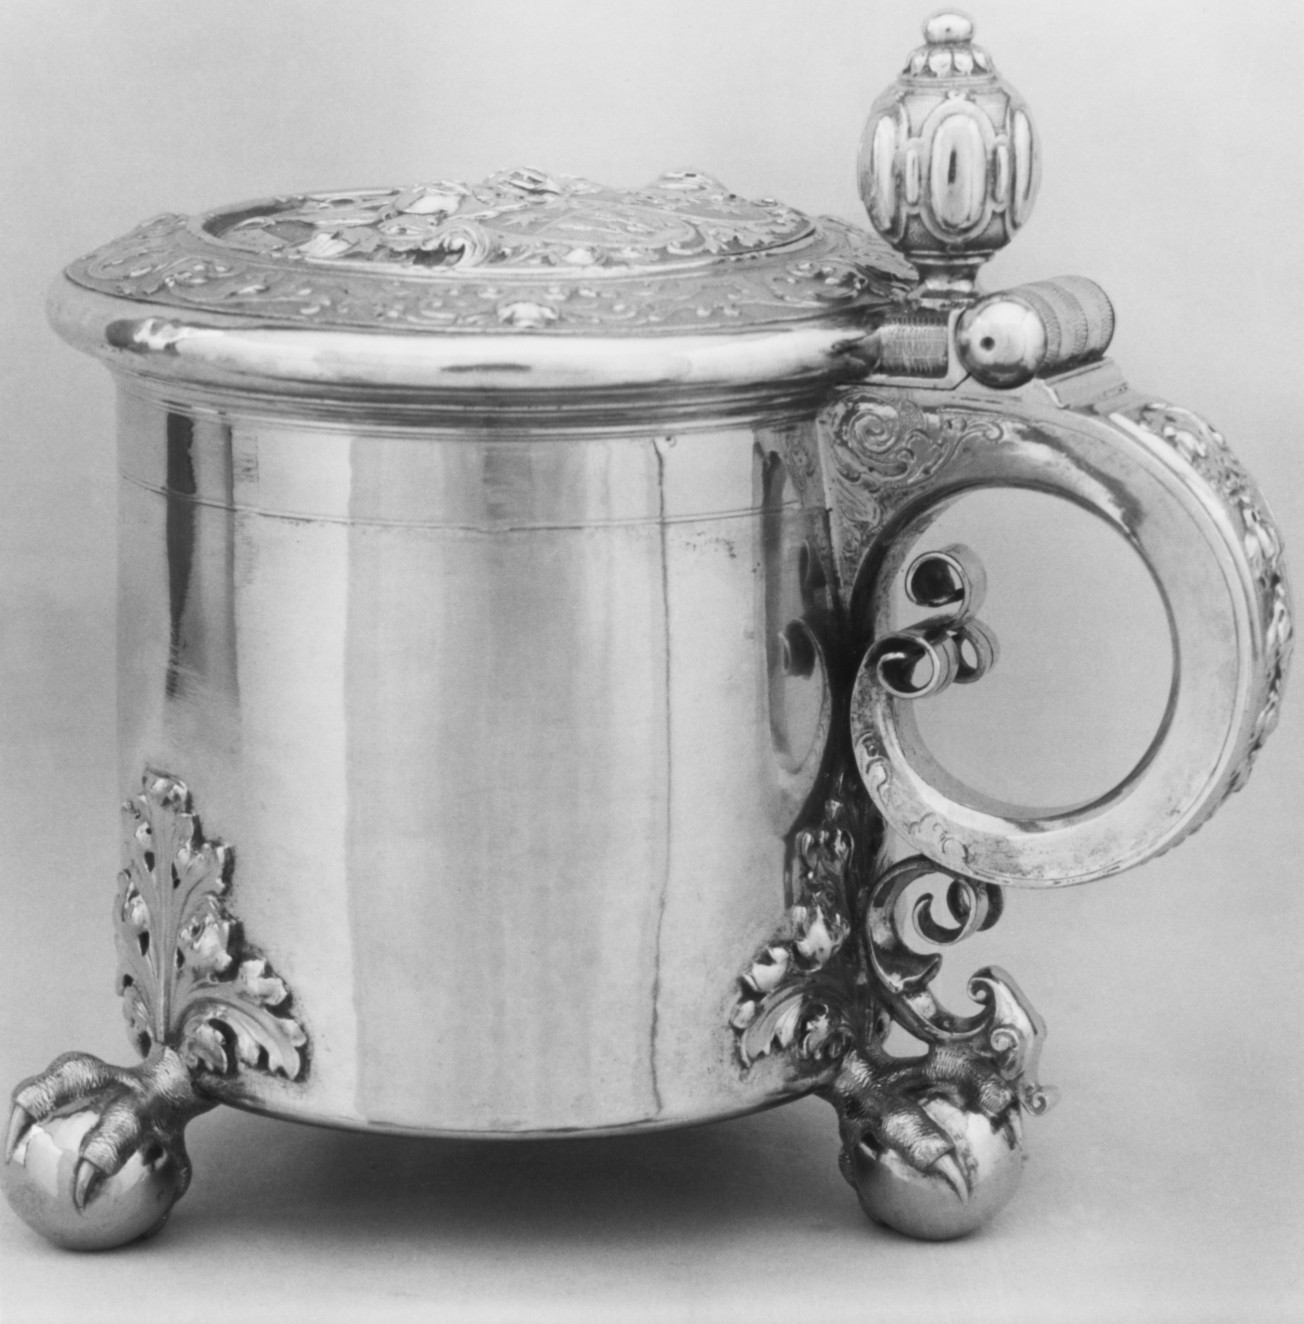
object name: tankard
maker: christoffer mansfeld ii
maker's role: maker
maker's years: 1685-1740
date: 1700-1735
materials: gilt, silver